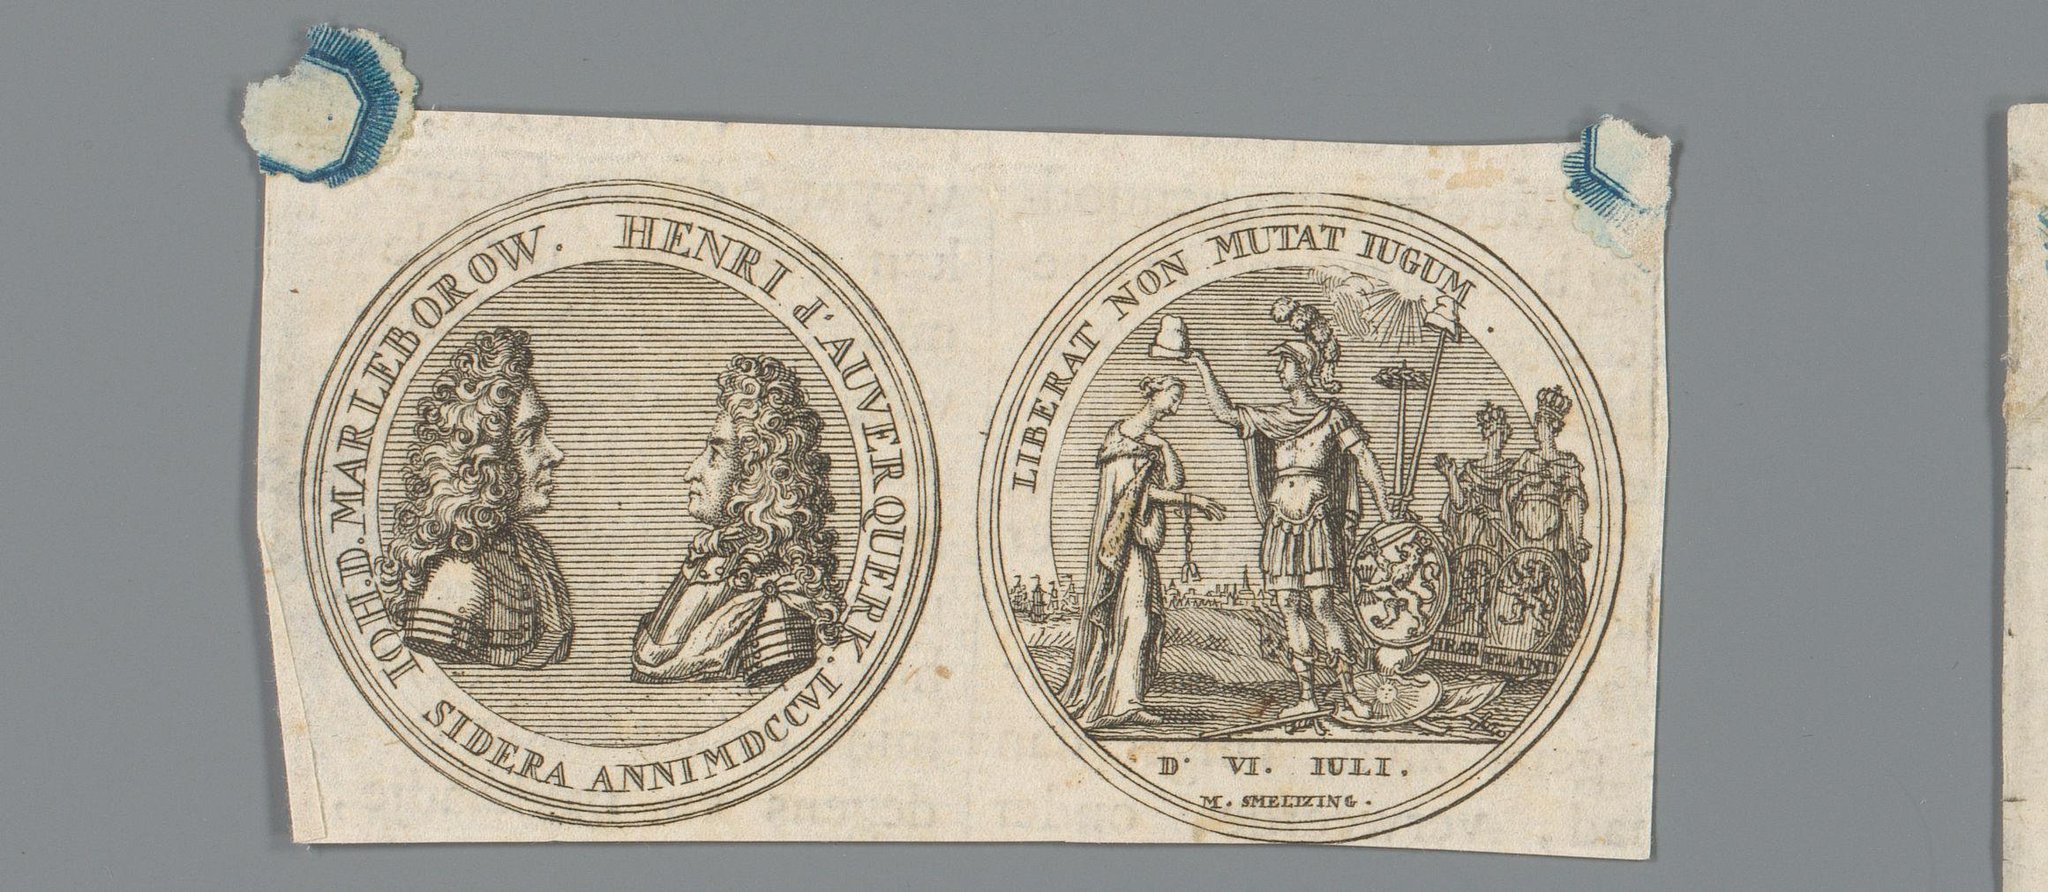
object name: book illustration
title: Voor- en achterzijde van een penning met het portret van John Churchill en Hendrik, graaf van Nassau-Ouwerkerk en personificaties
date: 1731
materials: paper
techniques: etching, letterpress printing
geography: the hague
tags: john churchill (1e hertog van marlborough), the hague, commander-in-chief, general, marshal, historical persons, coin, freedom, liberty; 'libertà' (ripa)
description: Prent uit: Loon, Gerard van. Beschryving der Nederlandsche Historipenningen: (...). Den Haag: Christiaan van Lom et al., 1731, dl. 4, p. 459.